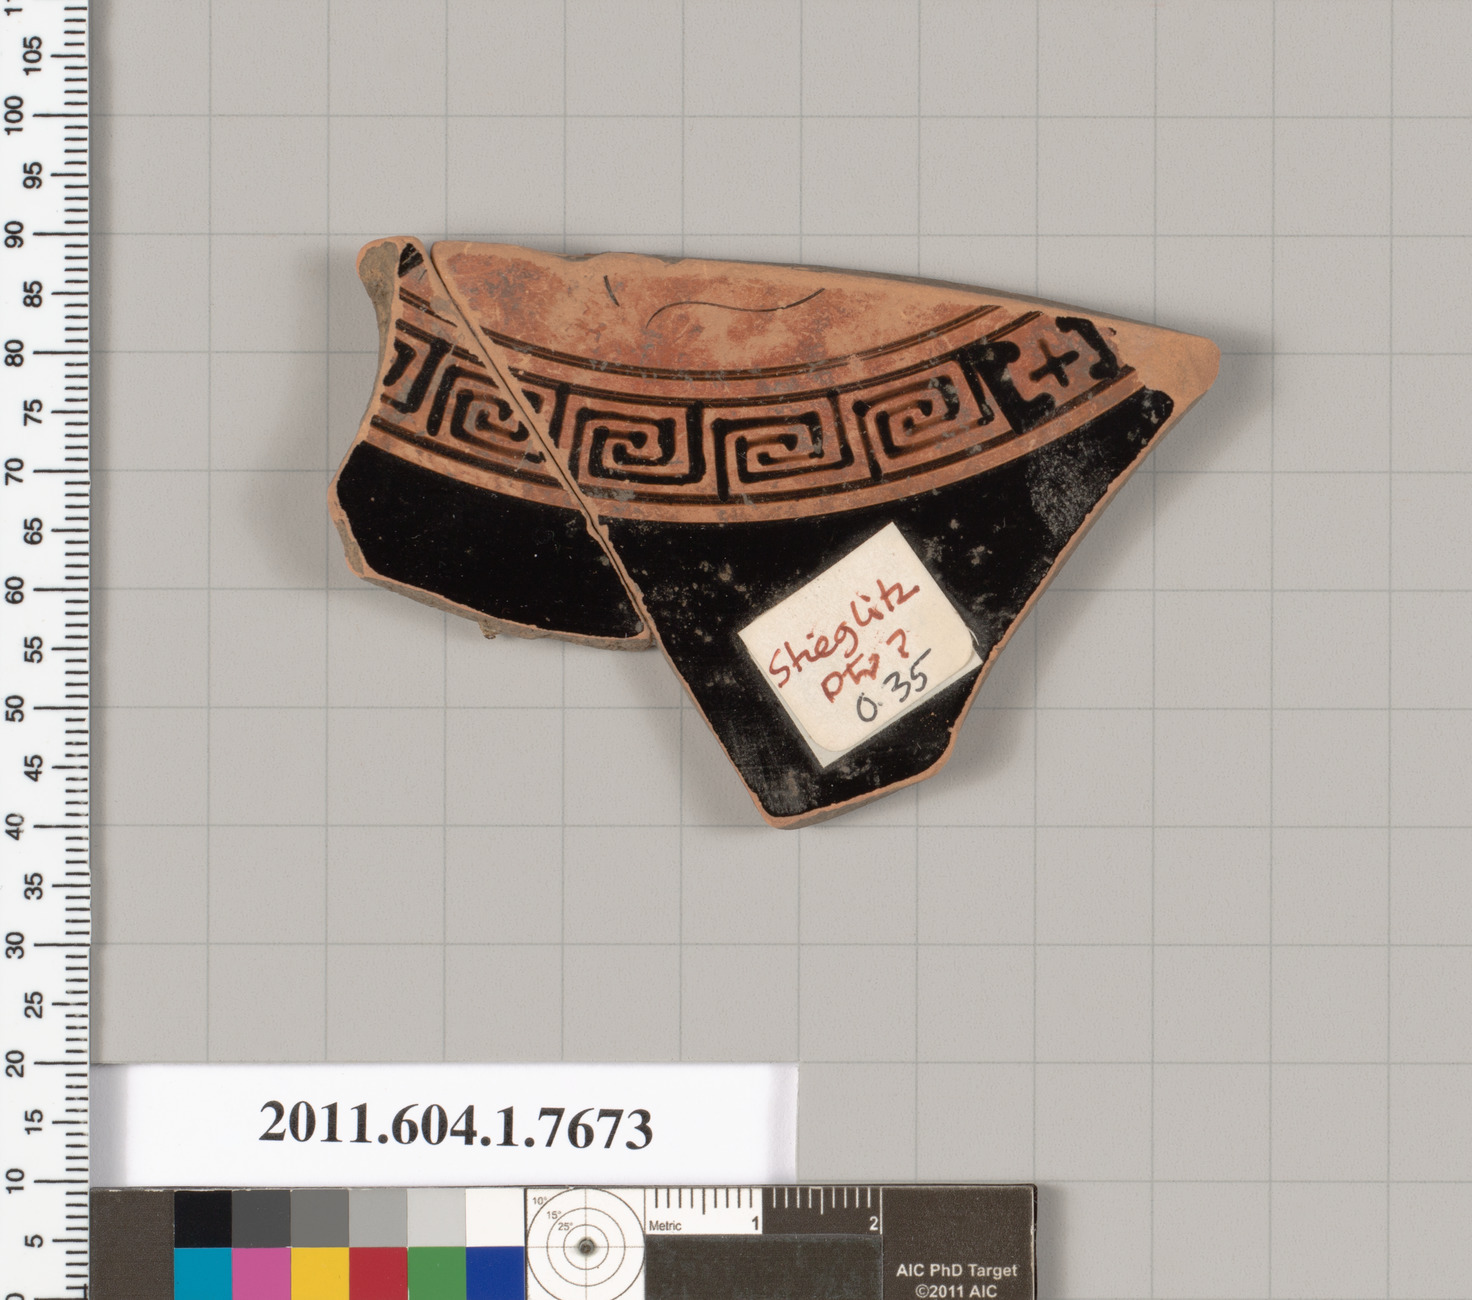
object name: kylix fragment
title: Terracotta fragment of a kylix (drinking cup)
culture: greek, attic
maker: stieglitz painter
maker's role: artist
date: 480-470 BCE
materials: terracotta